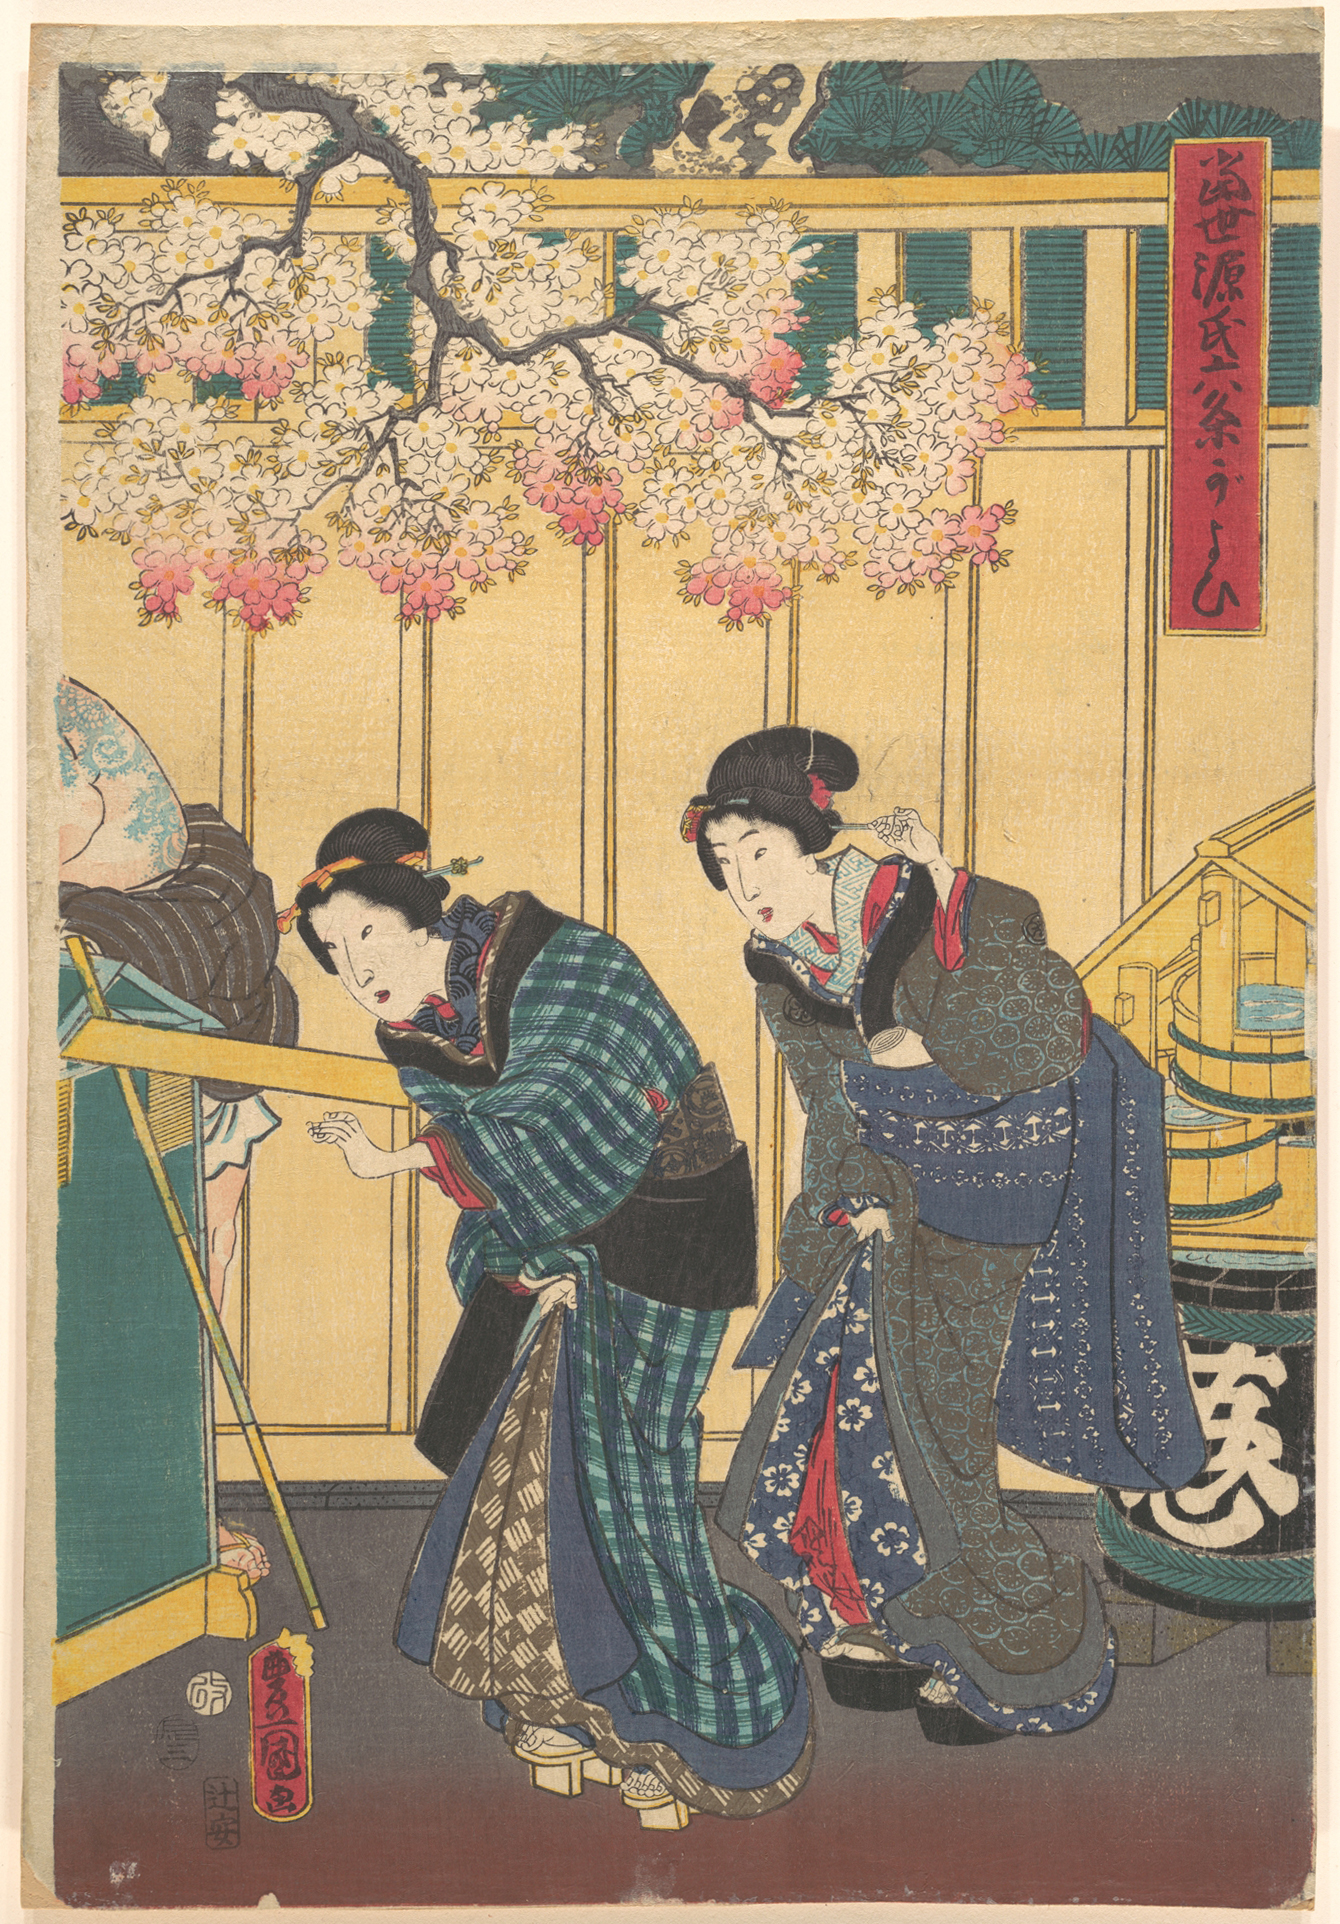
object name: print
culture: japanese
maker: utagawa kunisada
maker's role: artist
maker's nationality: japanese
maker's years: 1786-1864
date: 1786-1854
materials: ink, paper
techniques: woodblock print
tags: women,flowers,trees